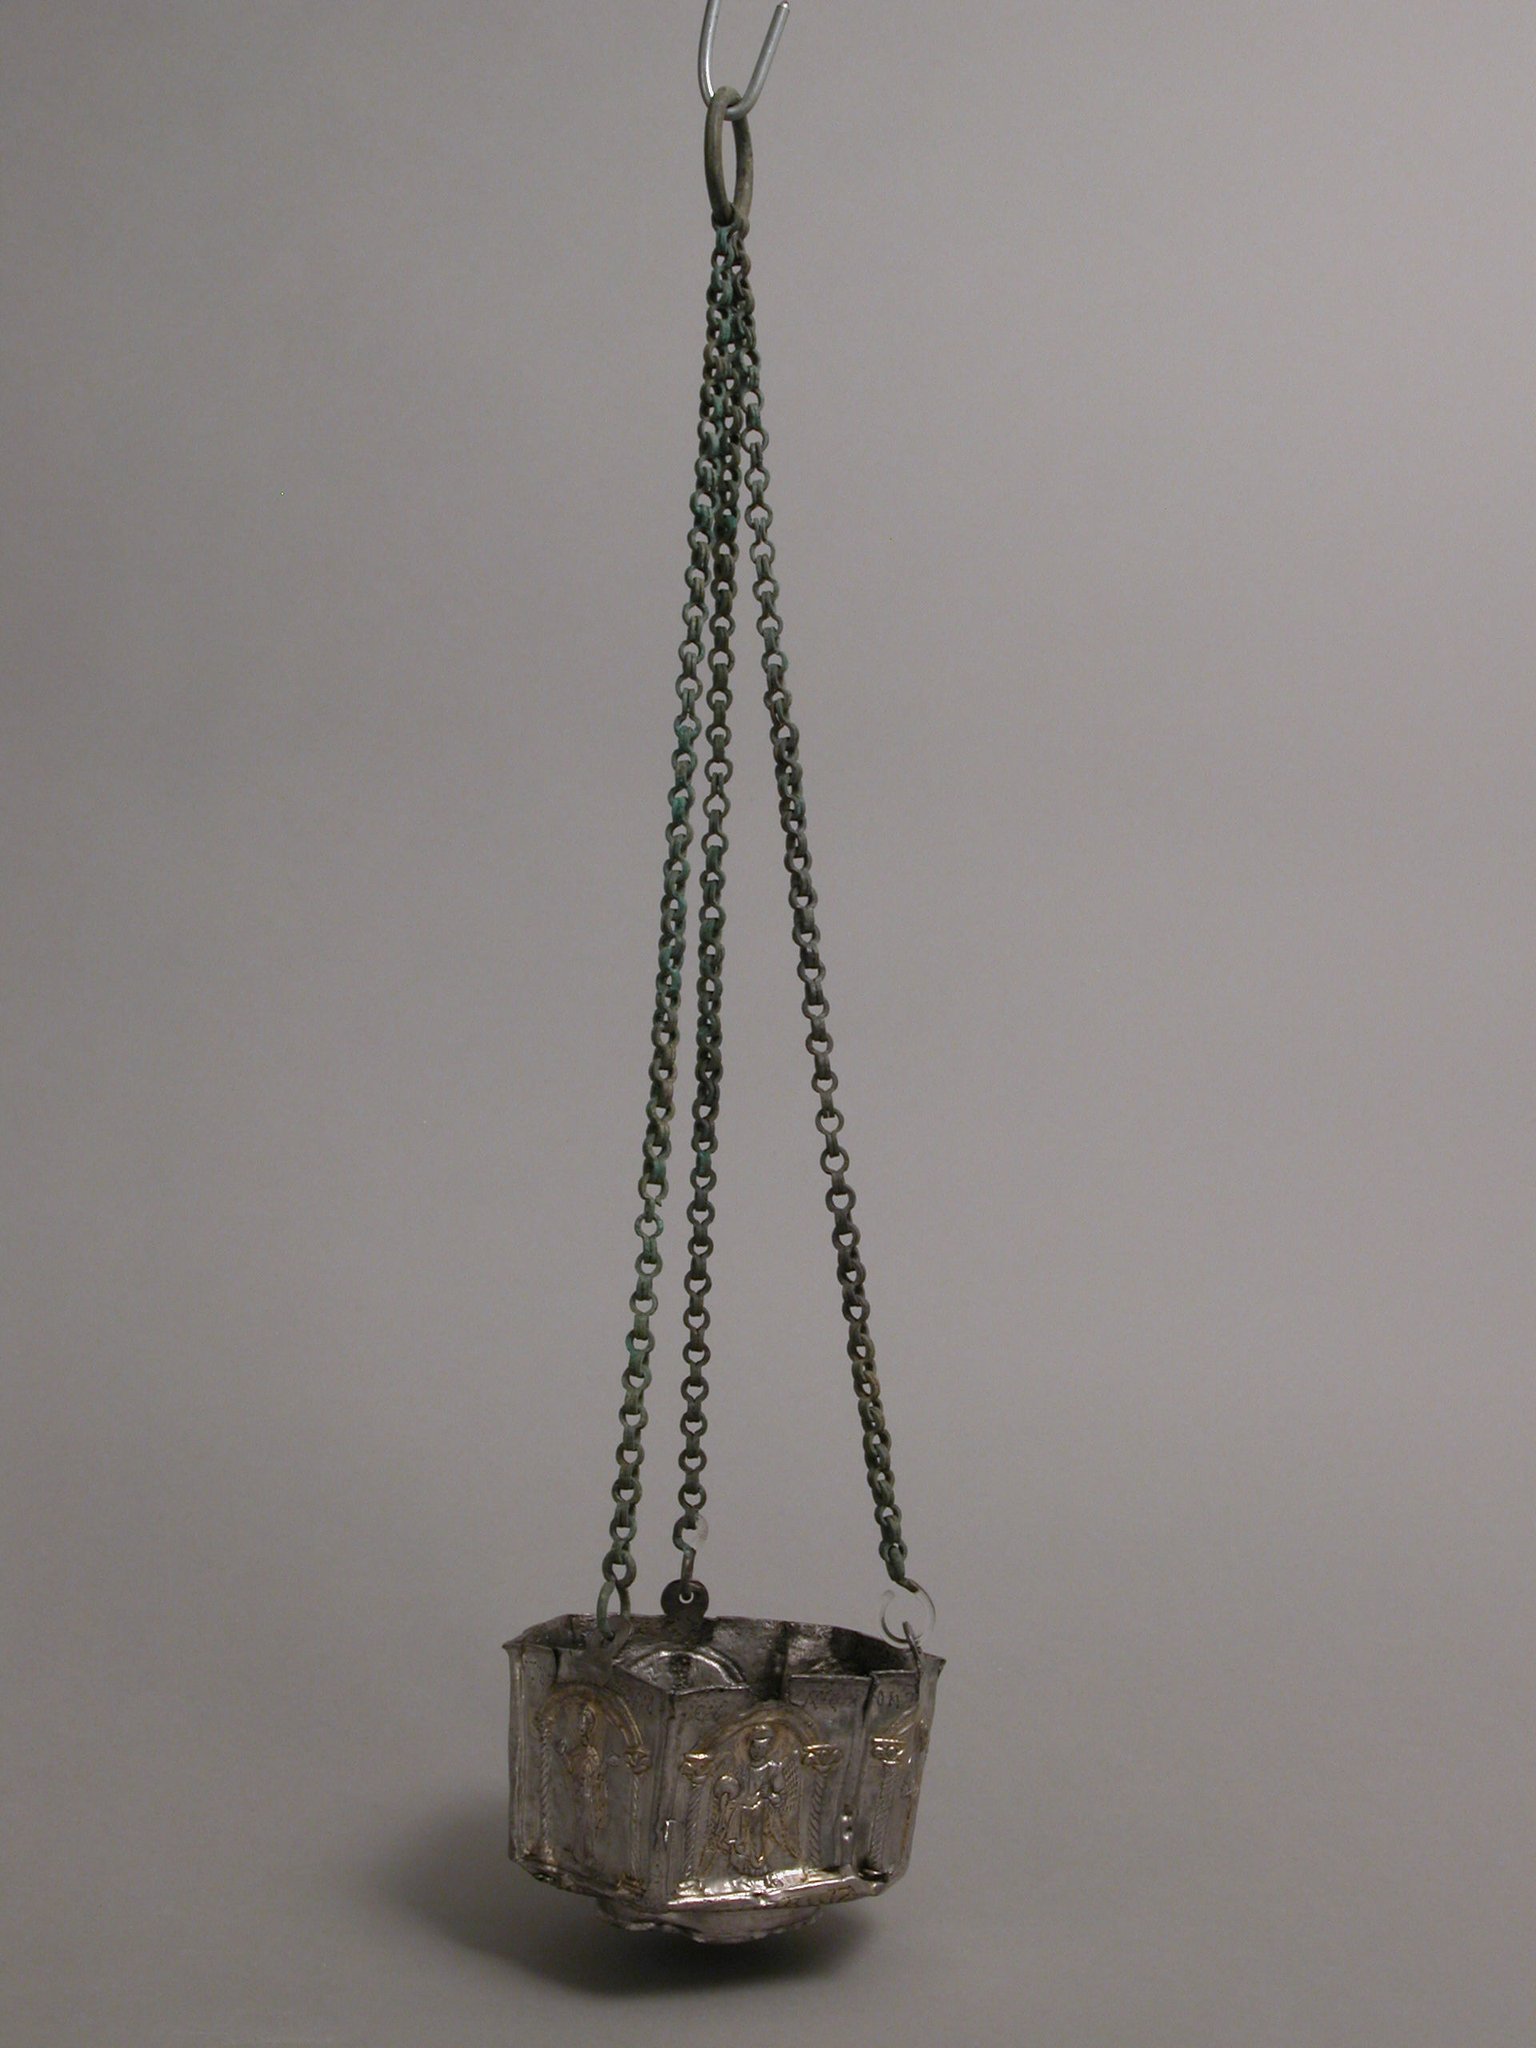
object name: censer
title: Censer with Six Holy Figures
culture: byzantine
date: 582-602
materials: silver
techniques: gilding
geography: probably constantinople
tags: christ,saint paul,saint peter,virgin mary